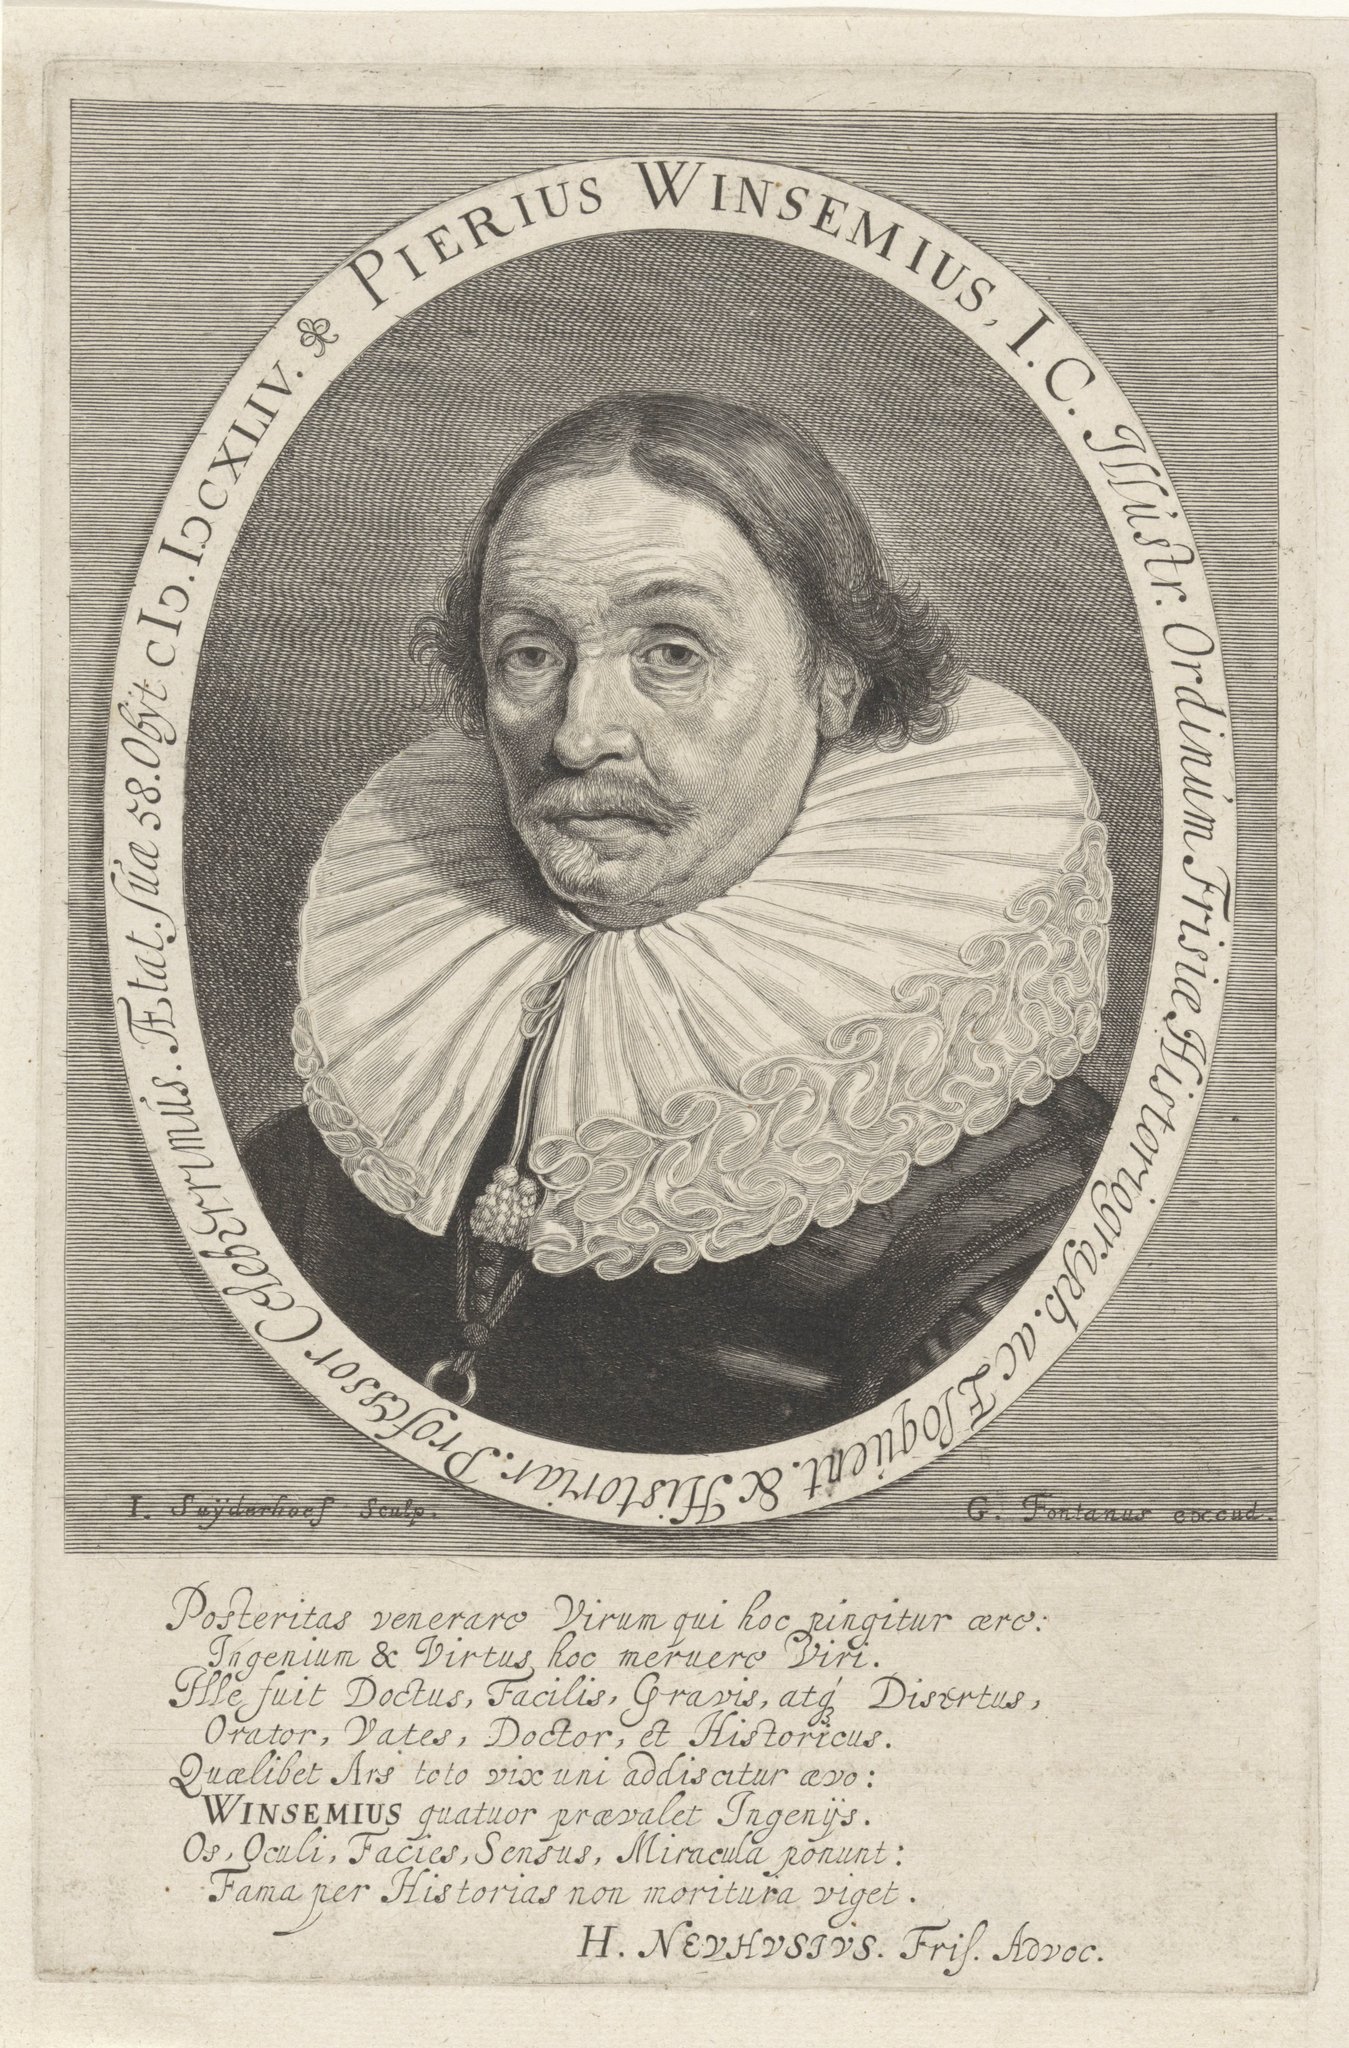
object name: print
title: Portret van Pier Winsemius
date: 1646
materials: paper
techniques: engraving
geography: haarlem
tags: pier winsemius, portrait of a writer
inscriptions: collector's mark: Lugt 240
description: Prent uit: Winsemius, Pierius. Historiarum ab excessv Caroli V. cæsaris. Sive Rerum sub Philippo II. per Frisiam gestarum. (...) libri septem. Leeuwarden: Claude Fonteyne, 1646.